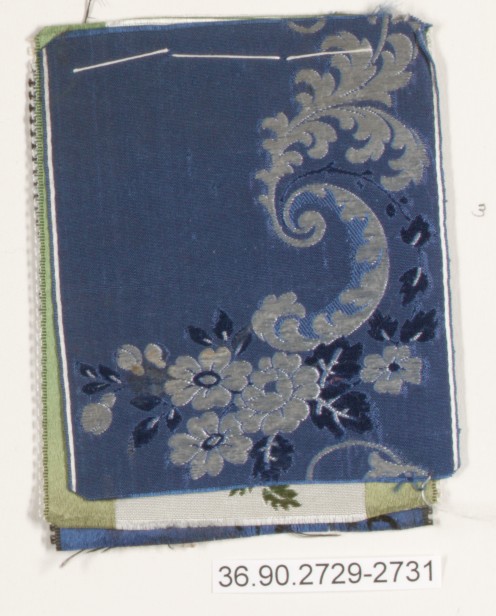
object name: ribbon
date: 1801-1900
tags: flowers